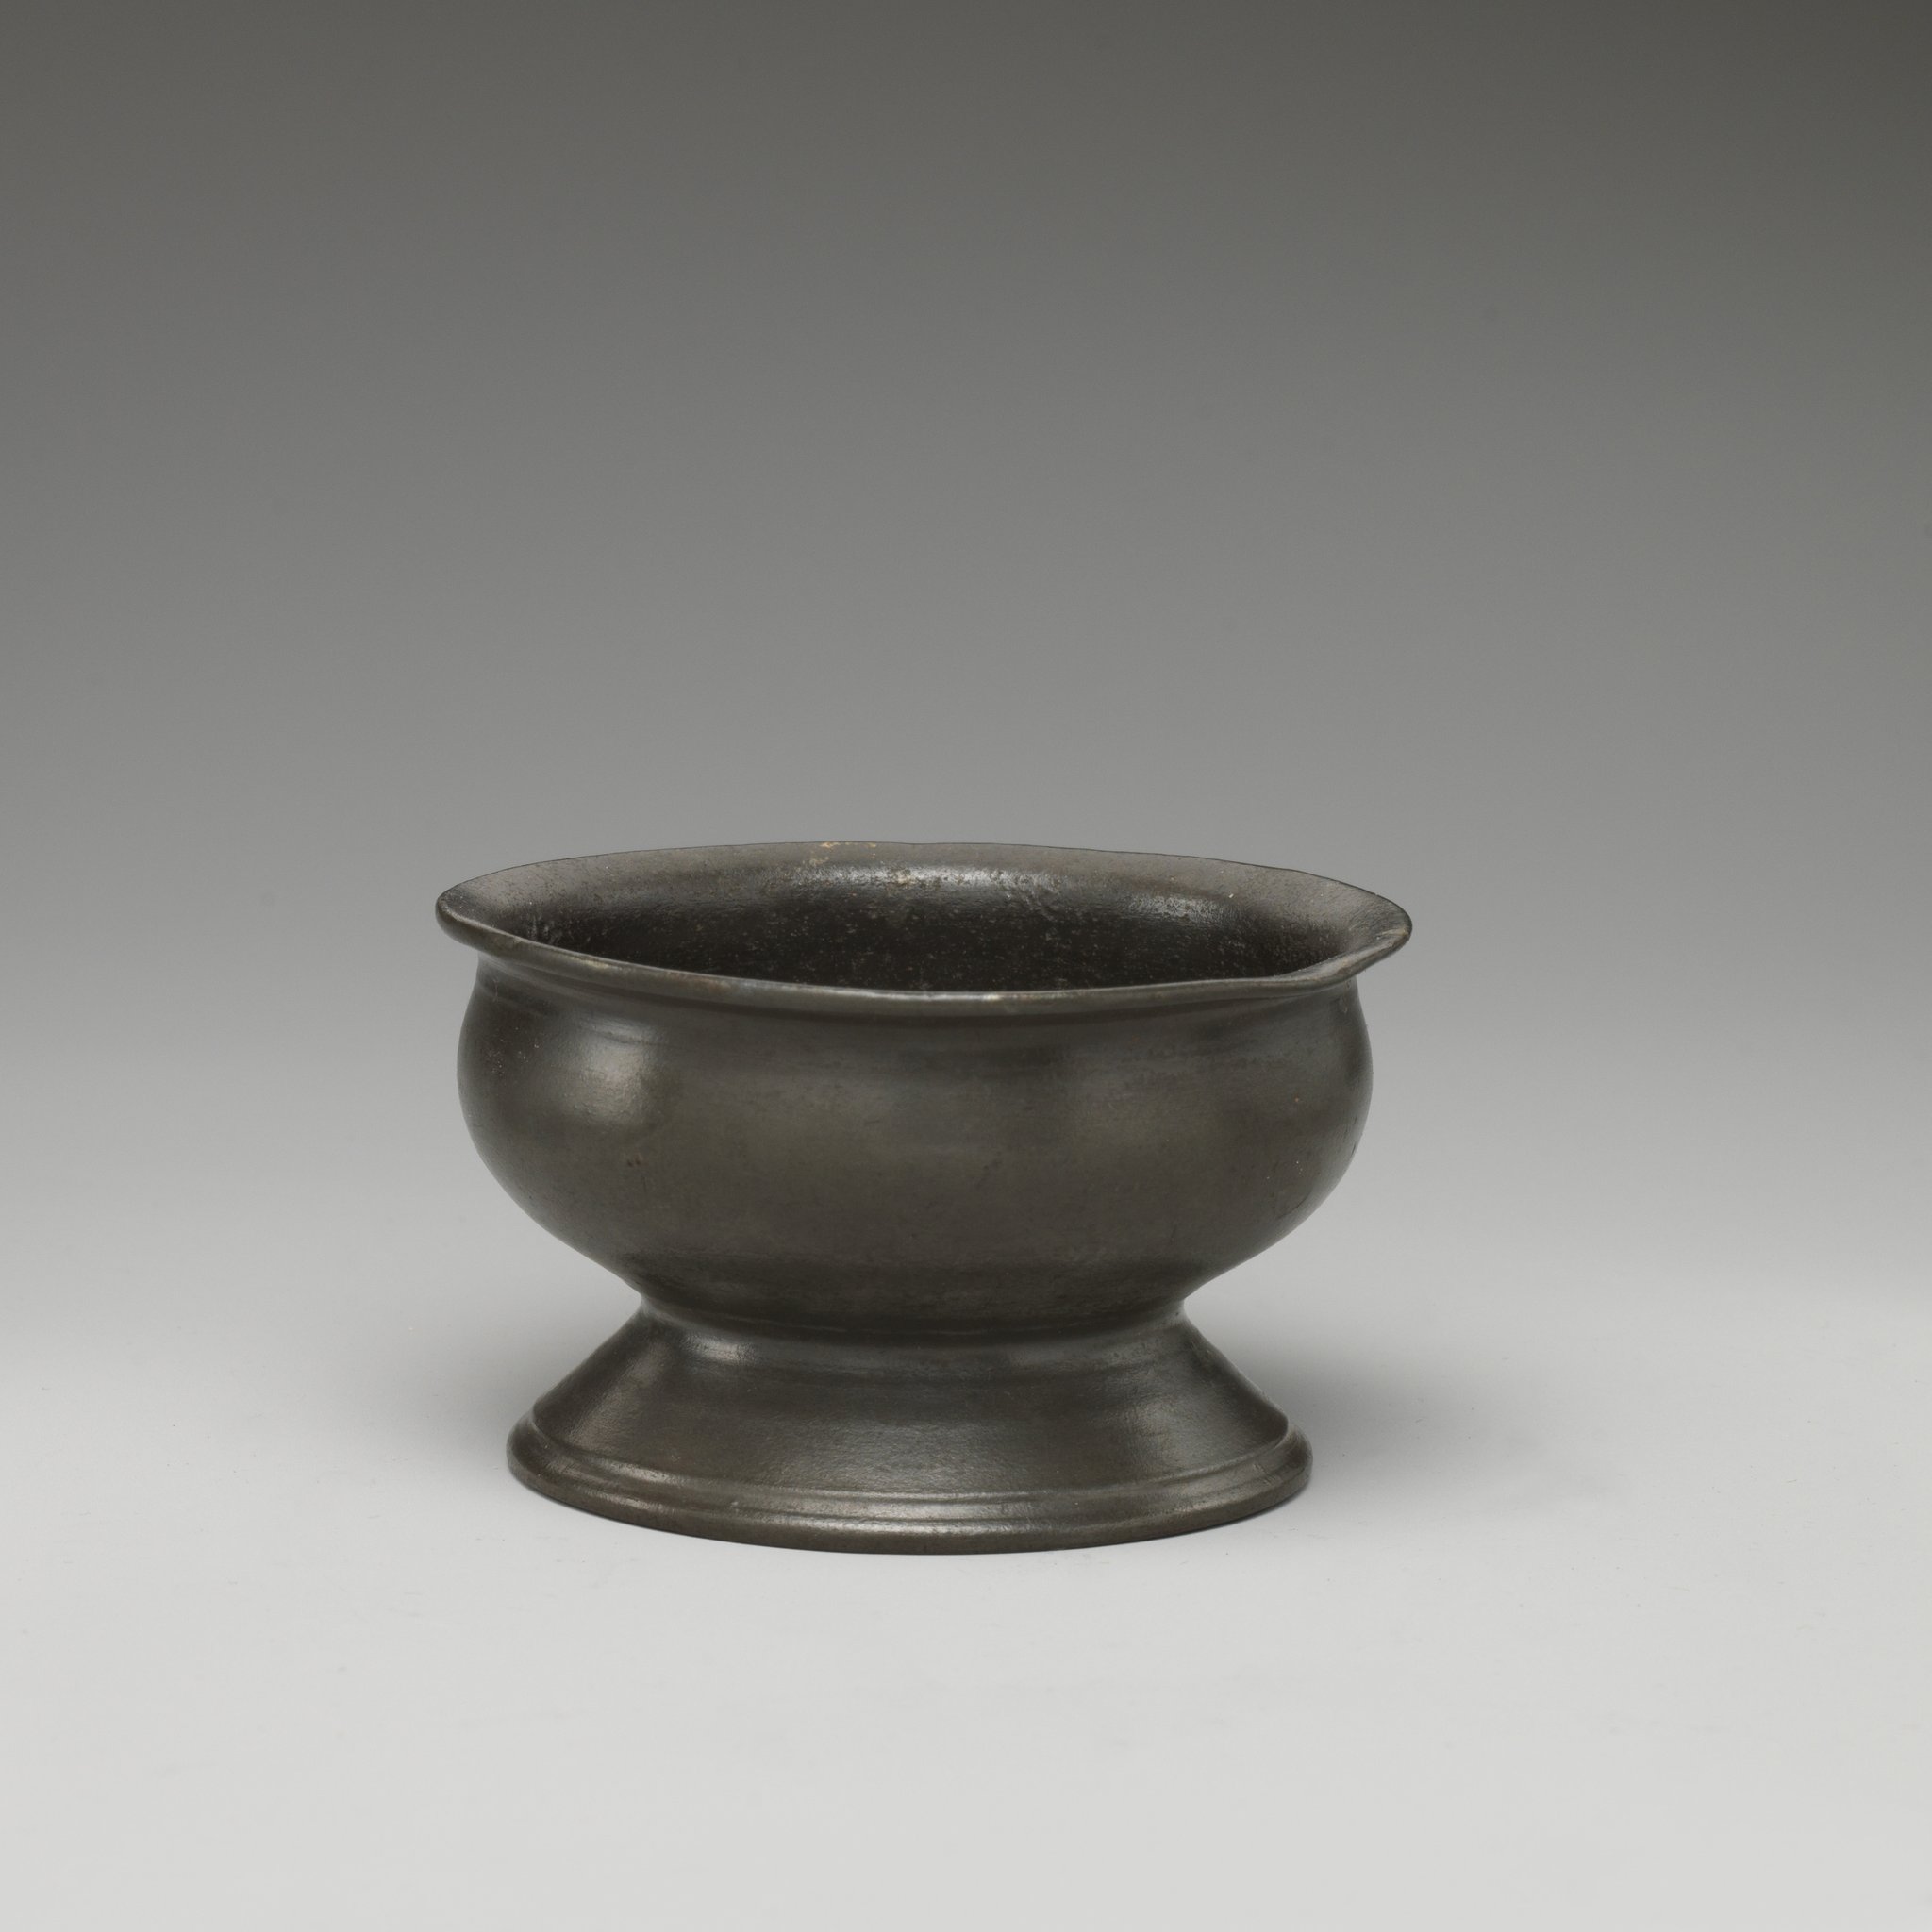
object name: saltcellar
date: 1701-1800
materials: pewter